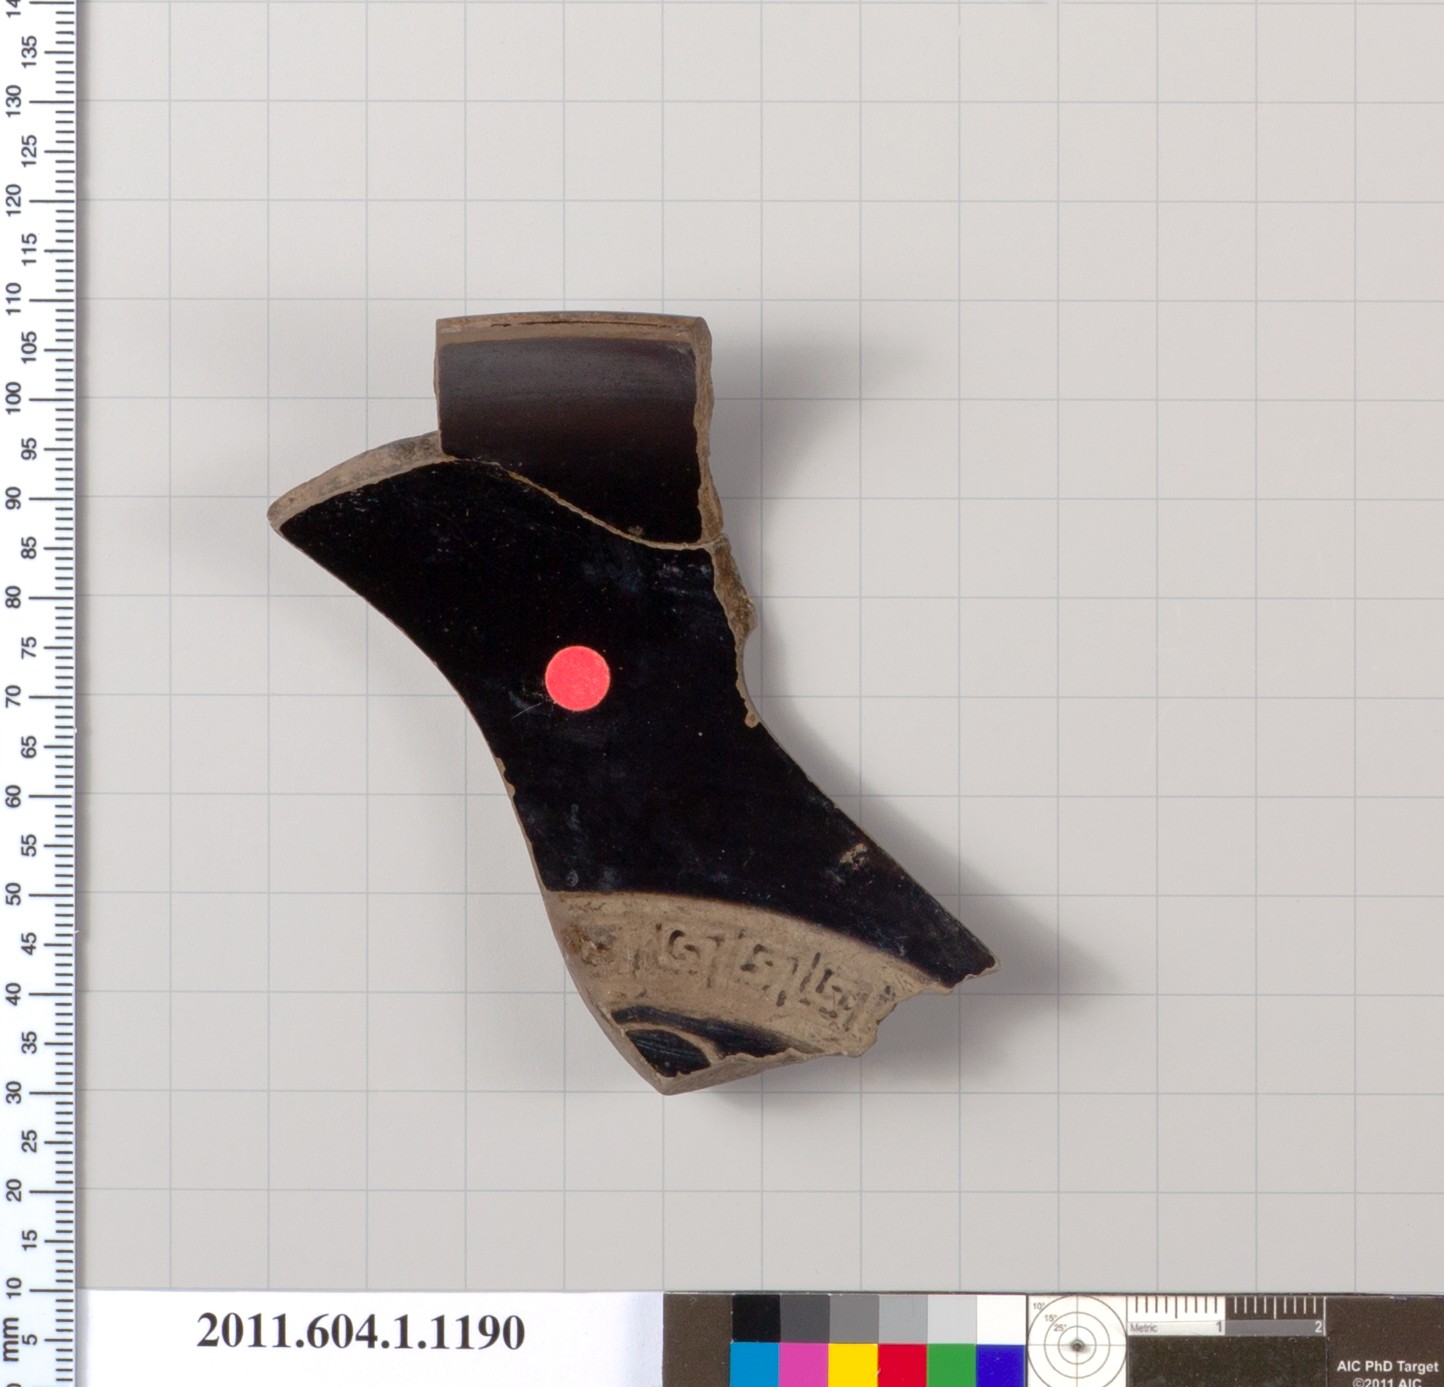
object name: kylix fragment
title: Terracotta rim fragment of a kylix (drinking cup)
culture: greek, attic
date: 490-480 BCE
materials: terracotta